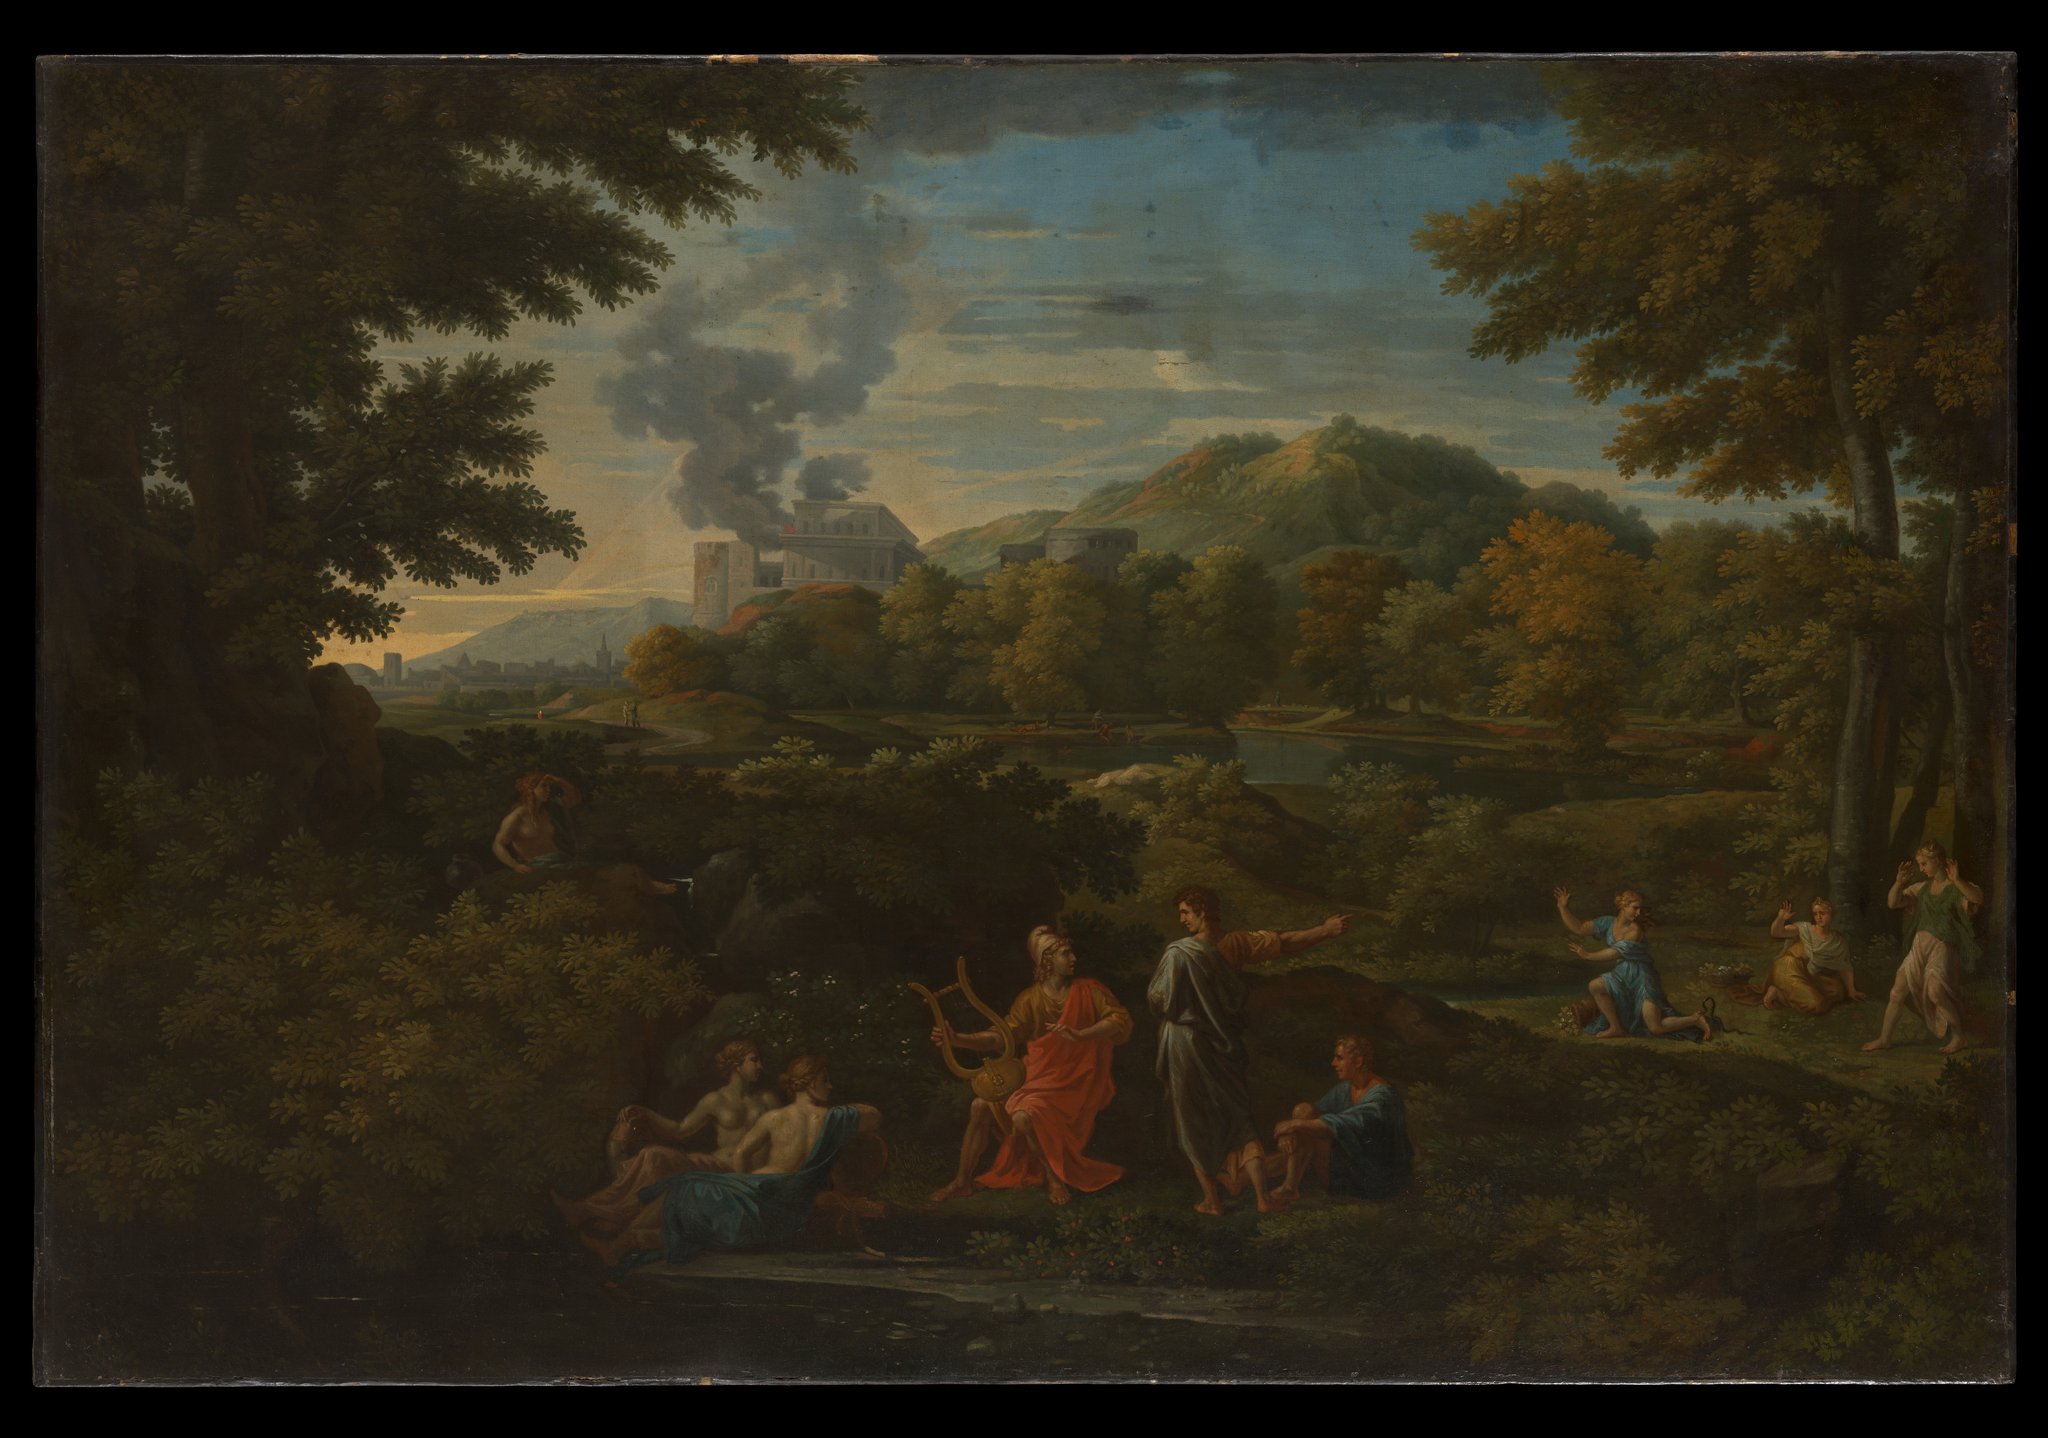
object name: painting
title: Orpheus and Eurydice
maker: nicolas poussin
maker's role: artist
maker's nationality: french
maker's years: 1594-1665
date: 1650-1674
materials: canvas, oil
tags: orpheus,forests,lyres,eurydice